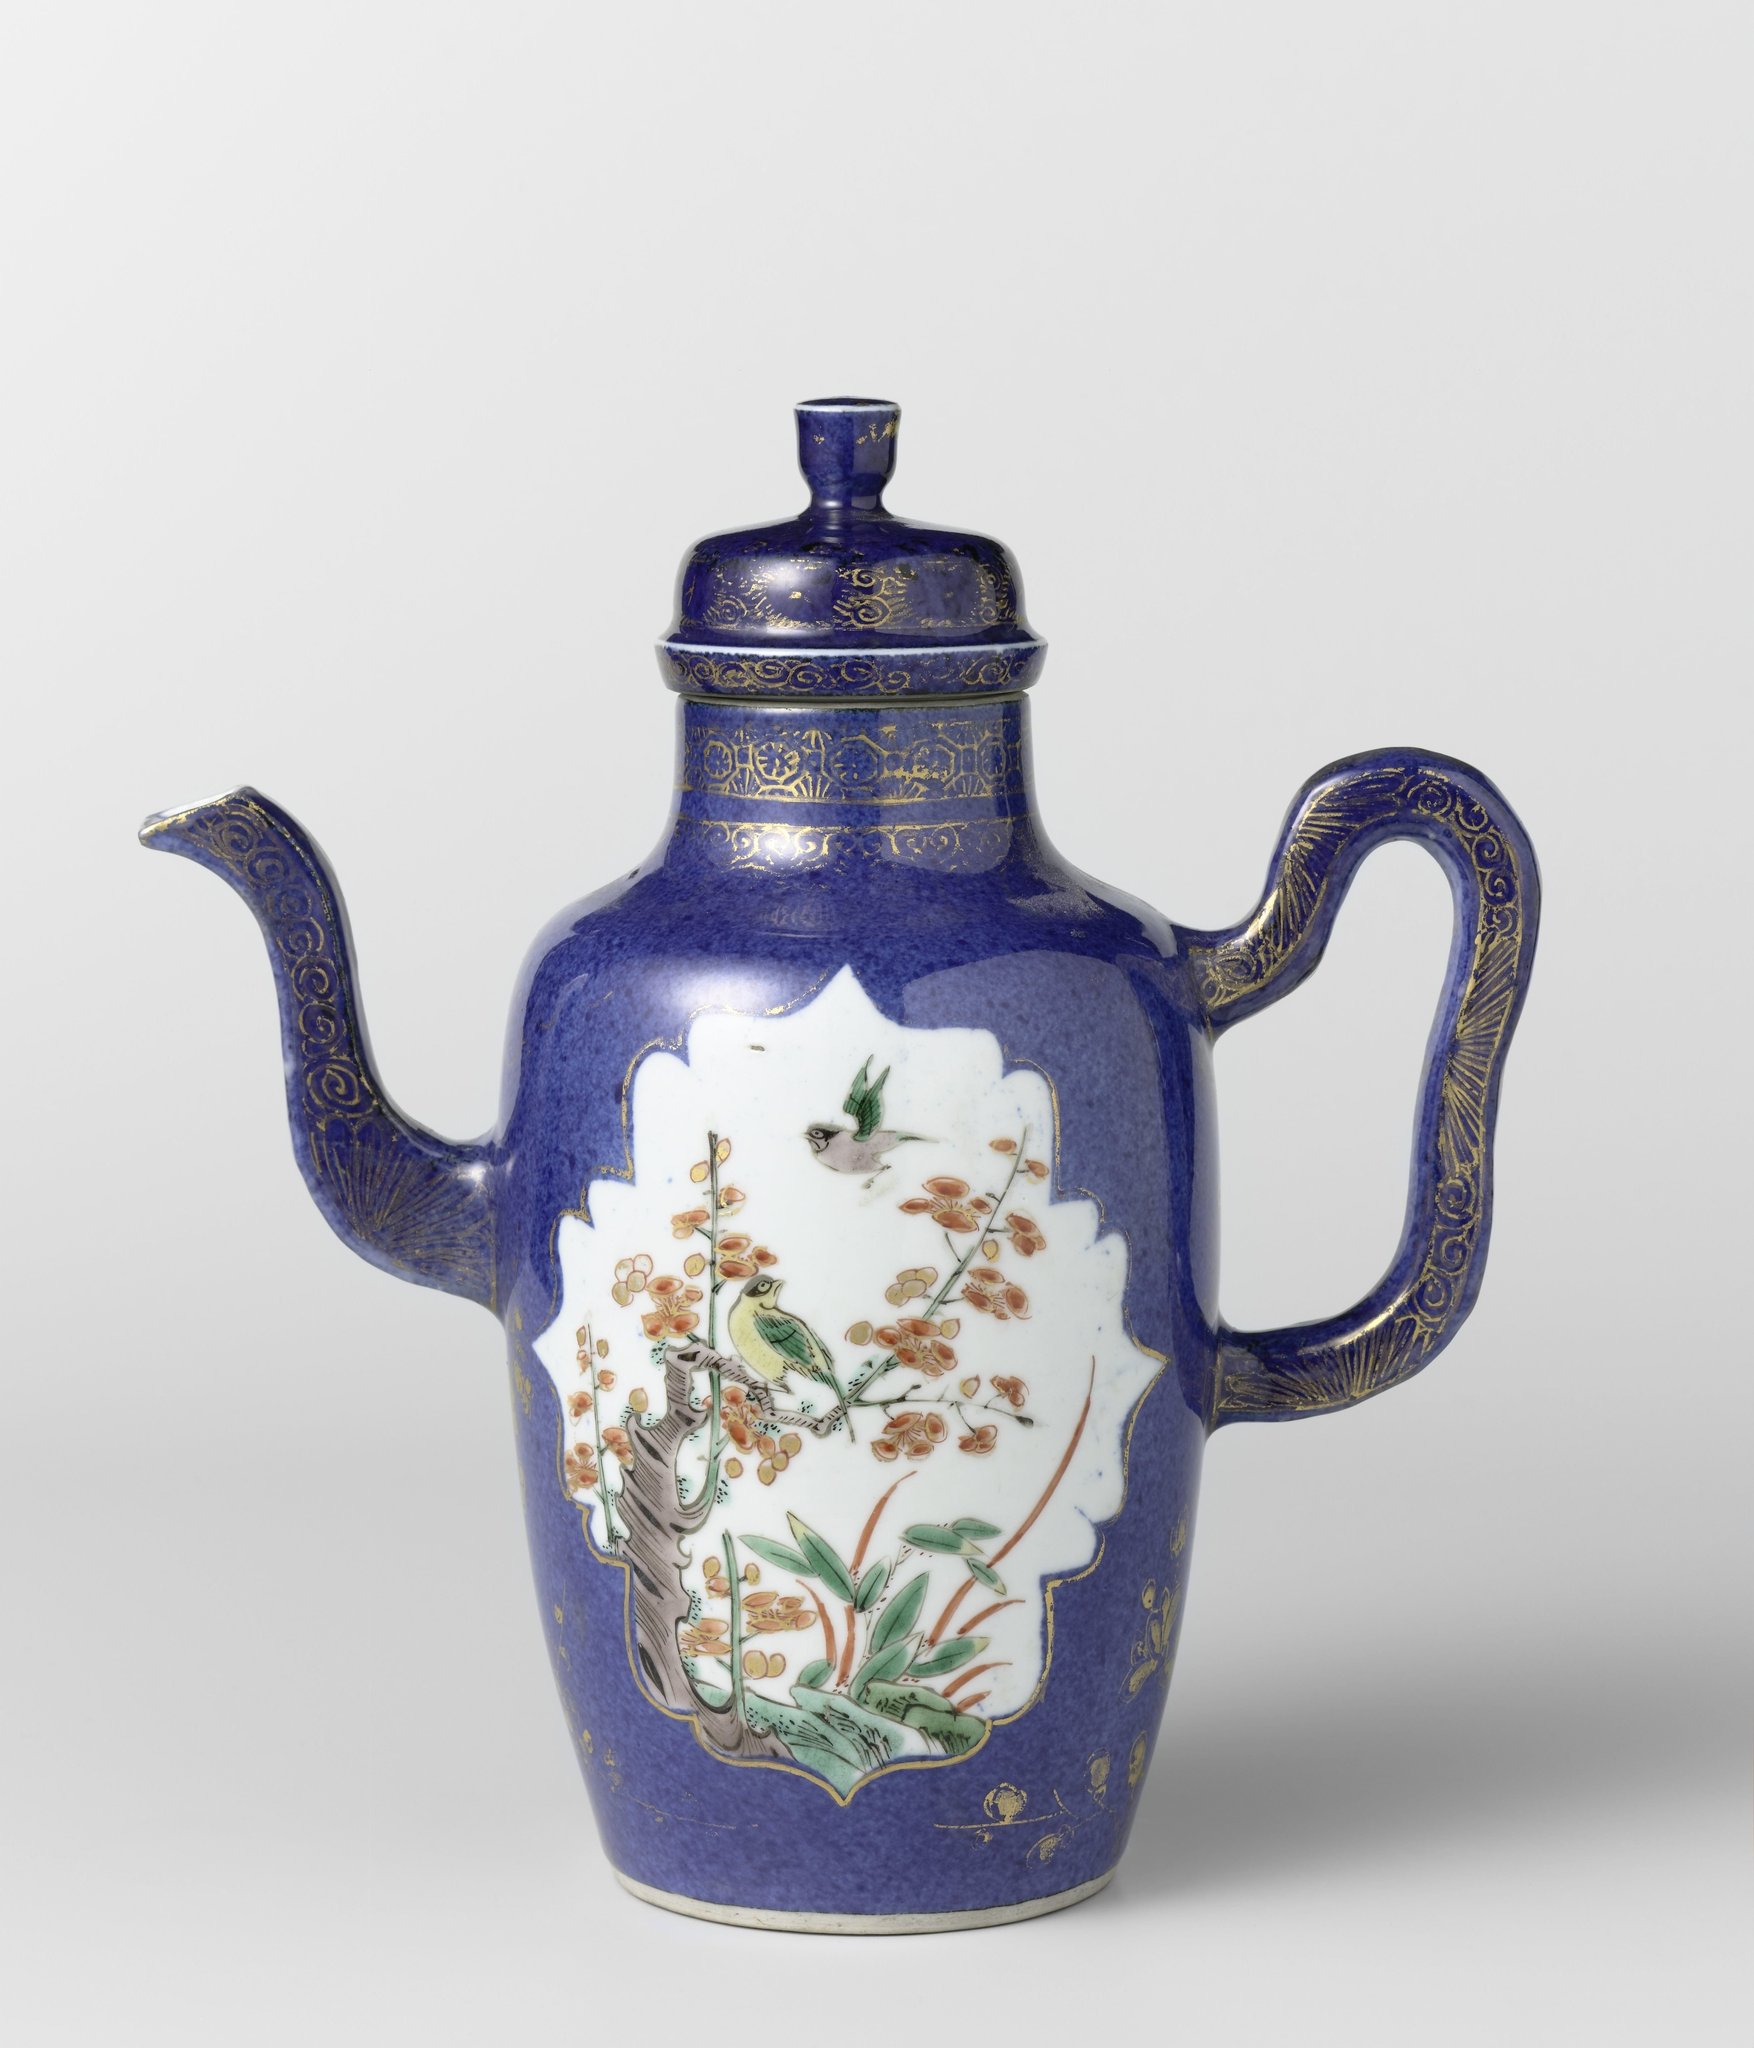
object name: teapot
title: Covered ewer with powder blue and panels in reserve with flower sprays and birds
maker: Anonymous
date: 1700-1724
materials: cobalt, glaze, gold, paint, porcelain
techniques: firing, gilding, turning, vitrification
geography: china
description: AK-NM-6365 Twee schenkkannen • Bleu poudré-porselein met verte • Onderdeel van Royers porseleincollectie • Mogelijk afkomstig van Susanna Louise Huygens • Gepubliceerd: Jörg 1997, nr. 156; Jörg 2011, nr. 125 De vorm van deze kan is gebruikelijk in China voor warme wijn. Of kannen met deze decoratie ook in China gebruikt zijn, of dat er voor poudré met verte alleen een markt in Europa bestond, is nog onduidelijk. De kannen zijn zorgvuldig gemaakt en beschilderd. Door de manier van afwerken en schilderen zijn ze verwant aan de knobbelfles AK-NM-6367. Hoewel ze als zeldzaam bekend staan, zijn er wel enkele identieke stukken in andere collecties bekend: In de collectie van Schloss Weissenstein te Pommersfelden, een van de residenties van de graven Von Schönborn, belangrijke mecenassen en verzamelaars uit Würzburg, bevindt zich een identiek exemplaar [Bott 1989, nr. 182] evenals in de Jie Rui Tang-collectie [Volk 2017, nr. 116]. In de particuliere collectie Gertrud Reemtsma bevindt zich een verwante kan: een kalebasvorm met oor en lange tuit [Hempel 1974, nr. 158]. Het schilderwerk is ook hier zeer verwant aan dat op Royers kannen. Waarschijnlijk kocht Royer zijn kannen in 1786 uit de nalatenschap van zijn oudtante Susanna Louise Huygens (1714-1785). Royer besteedde een groot bedrag aan de verwerving van lakwerk en porselein uit haar omvangrijke verzameling. In haar boedelbeschrijving vinden we: ‘Twee pyppotten of kannen als vooren [hoog blaauw] met vakken of compartimente waarin gecouleurde bloemen, vogels en capellen mede met vergulde ornamenten op de halzen en dekzels.’ Dat is een accurate omschrijving van Royers kannen. Bronnen: Rose Hempel, Tausend Jahre chinesische Keramik aus Privatbesitz, Hamburg 1974. G. Bott (red.), Die Grafen von Schönborn, Kirchfürsten, Sammler, Mäzene (tent.cat. Germanisches National Museum) Neurenberg, 1989. Jeffrey P. Stamen and Cynthia Volk, A culture revealed: Kangxi-era Chinese porcelain from the Jie Rui Tang collection, Boston, 2017.